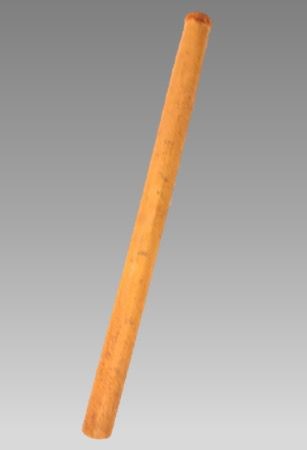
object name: pupa horn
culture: melanesian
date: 1867-1900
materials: bamboo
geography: solomon islands